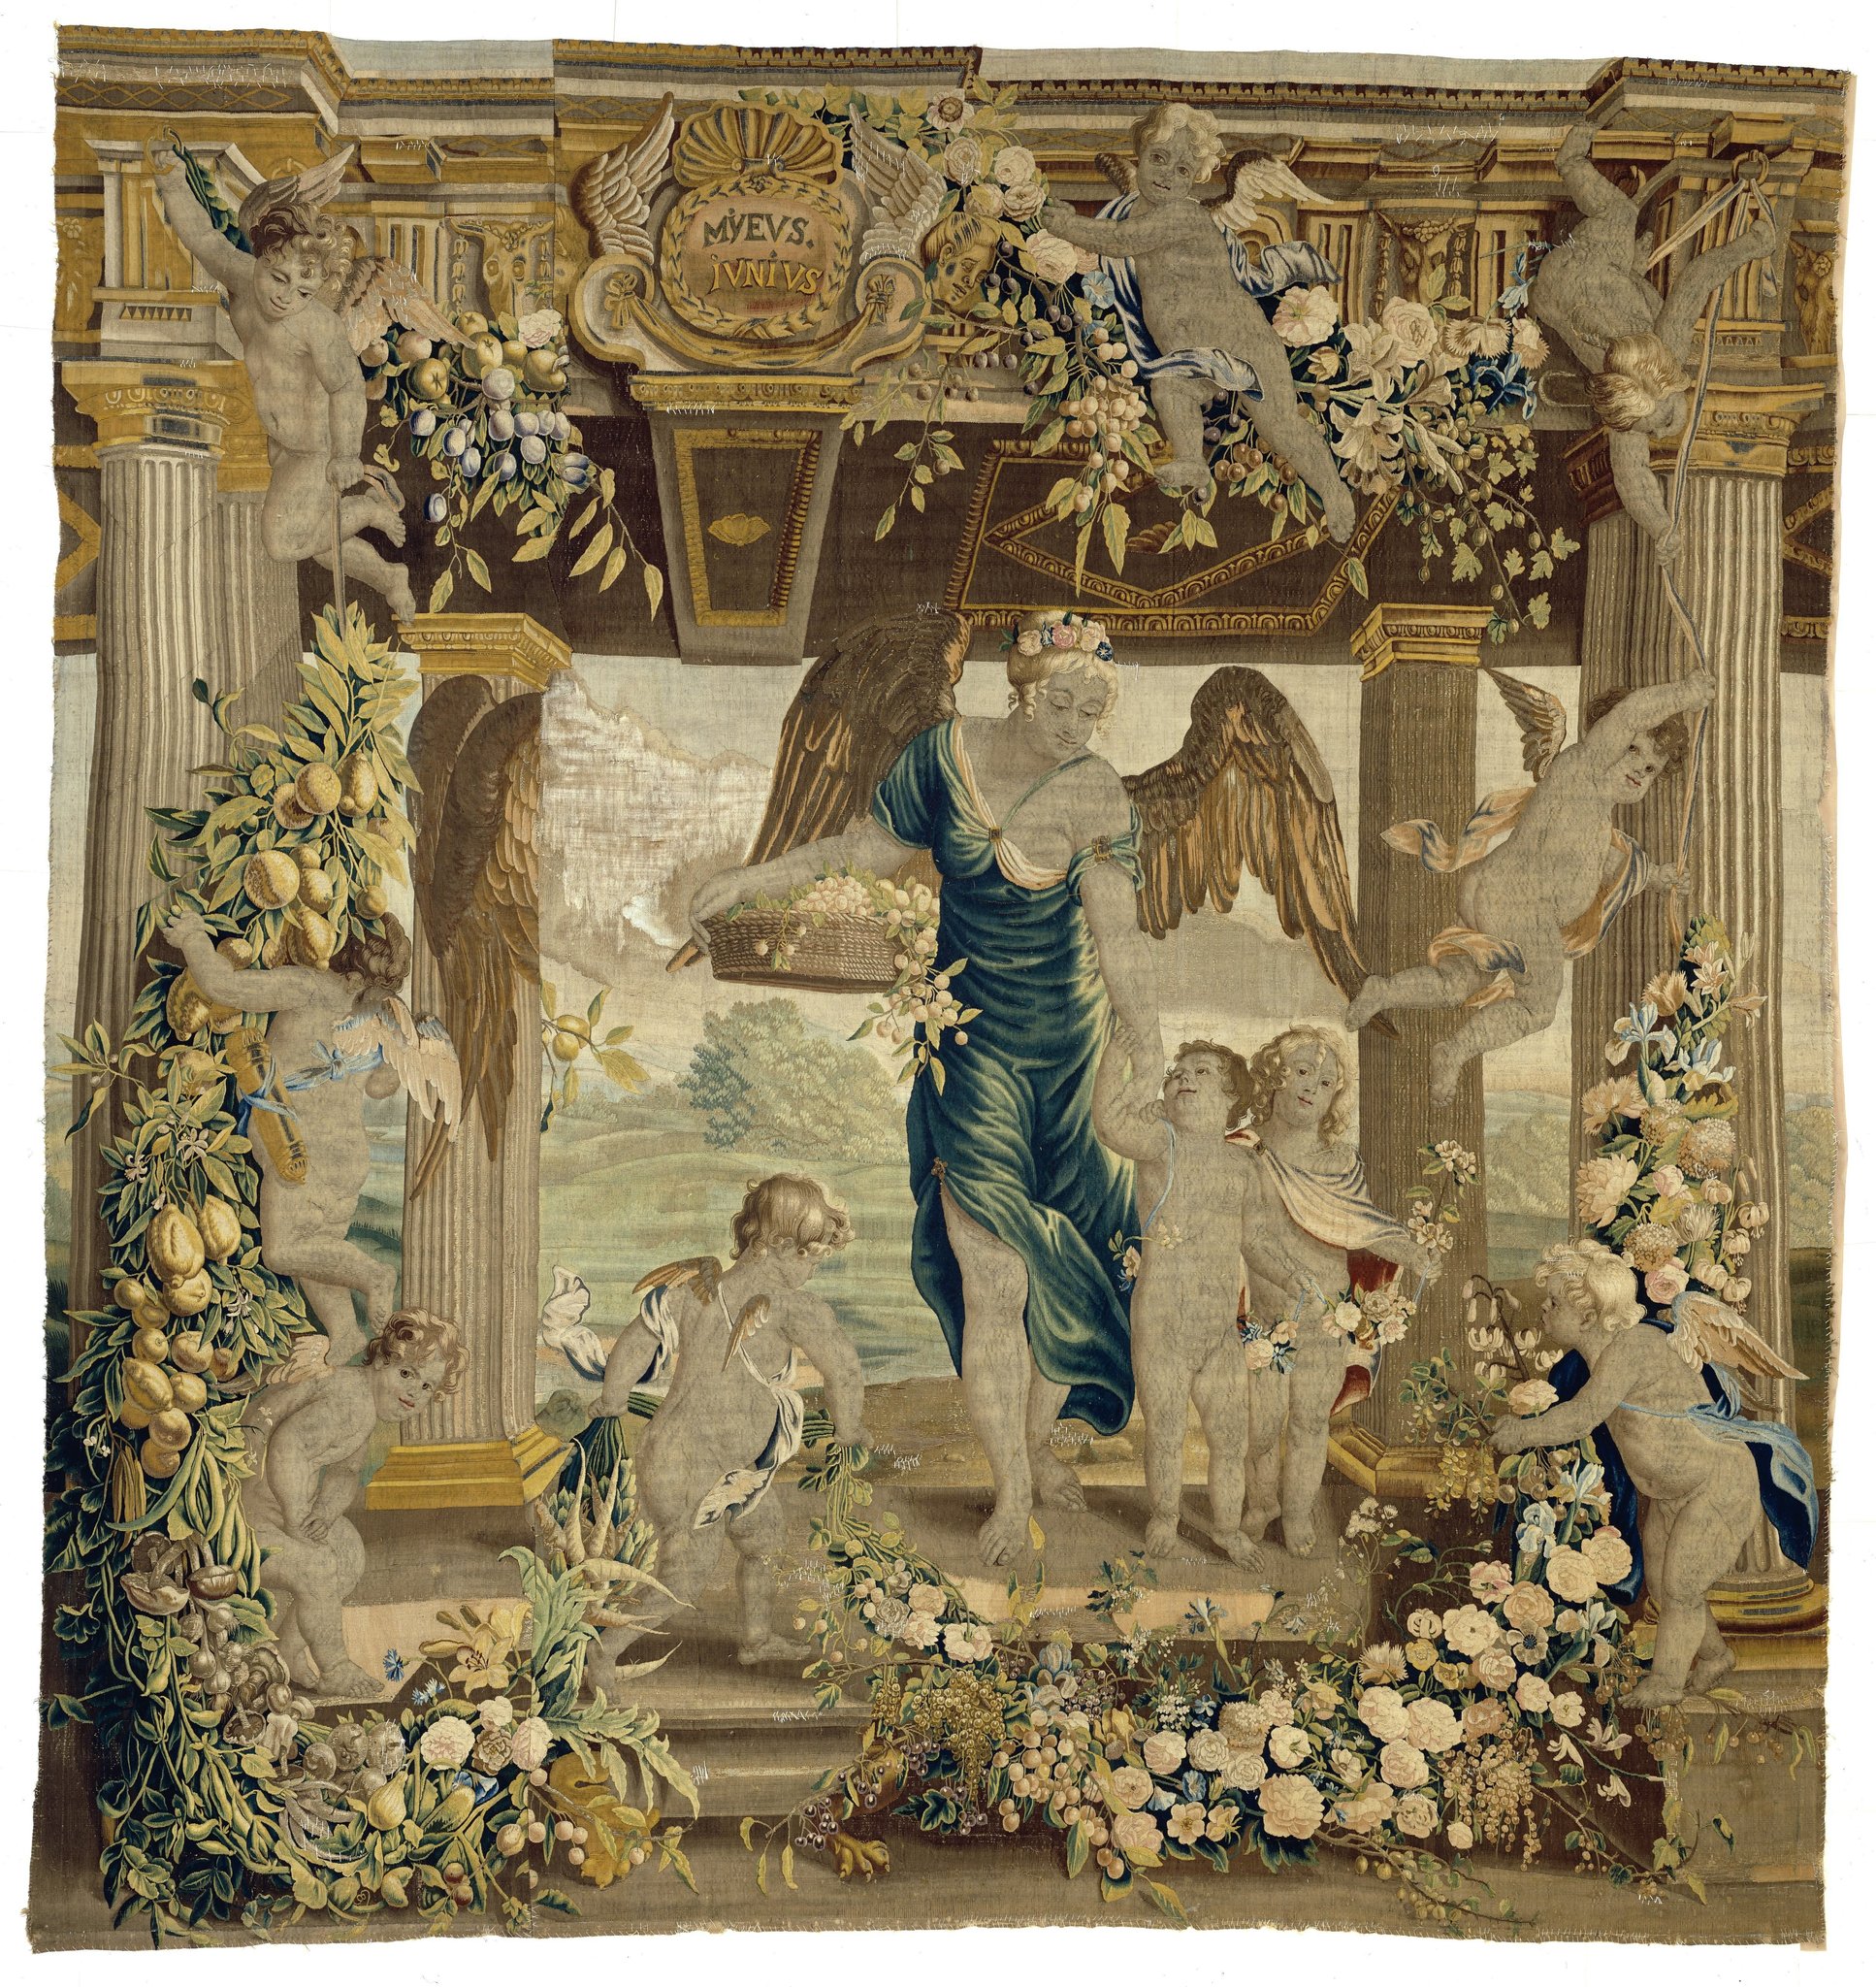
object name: tapestry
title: De maanden, seizoenen, elementen, dag en nacht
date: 1650-1680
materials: metal thread, silk, wool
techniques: tapestry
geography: antwerp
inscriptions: inscription: ‘MEYVS // IVNIVS’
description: Fragment van een wandtapijt voorstellende Mei en Juni, behorende tot een serie van tien met de maanden, elementen, seizoenen, dag en nacht. De serie werd vervaardigd in opdracht van aartshertog Leopold Wilhelm, stadhouder der Zuidelijke Nederlanden. Op dit fragment wordt een gevleugelde vrouw vergezeld door het sterrenbeeld Tweelingen en verbeeldt de maand mei. Vijf andere wandtapijten uit de collectie behoren eveneens tot deze serie (inv.nr. BK 15310 a-d en BK 1959-65)